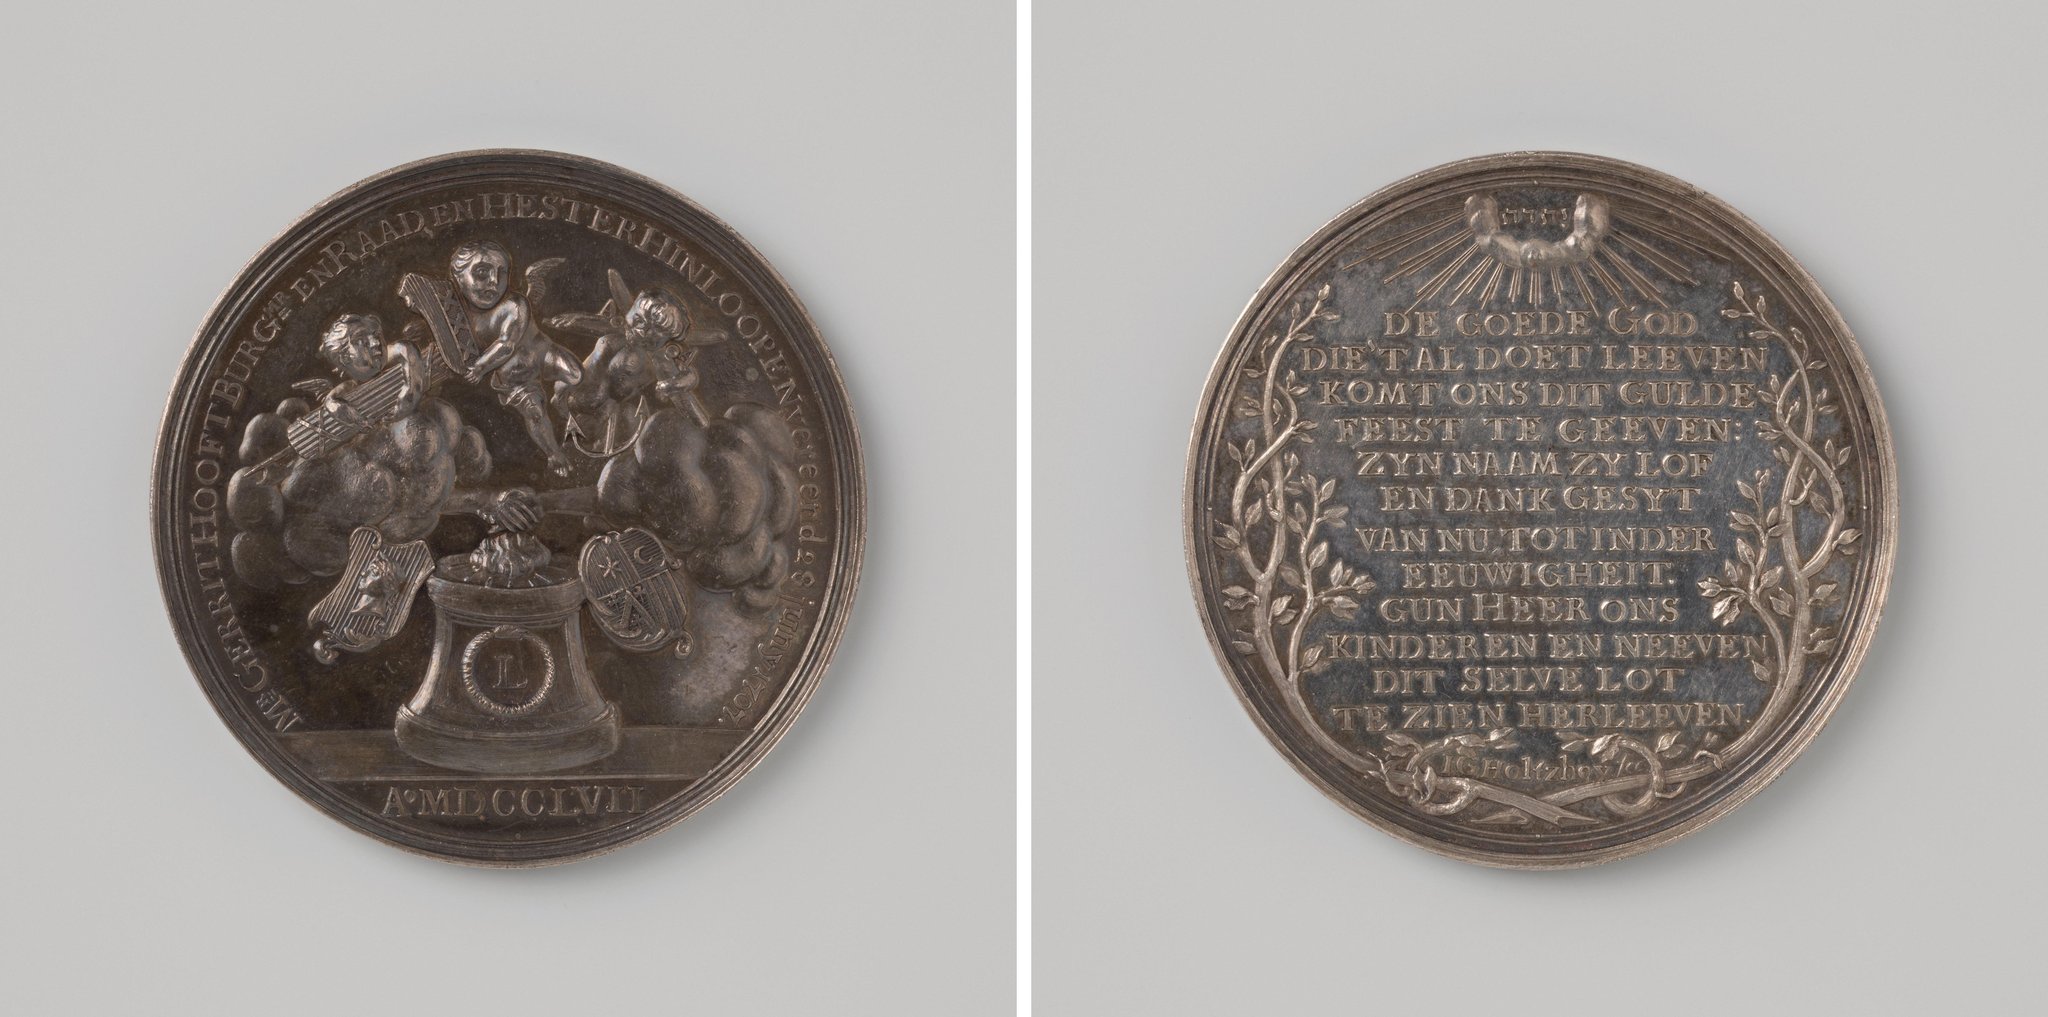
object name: history medal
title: Vijftigjarig huwelijk van Gerrit Hooft, burgemeester van Amsterdam, en Hester Hinloopen 1757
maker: johan george holtzhey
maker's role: mintmaster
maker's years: 1726-1808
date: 1757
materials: silver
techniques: striking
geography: amsterdam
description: Zilveren penning,op de voorzijde boven een altaar twee ineengedrukte handen uit wolken waaraan familiewapens hangen, waarboven drie gevleugelde knaapjes met fasces, Amsterdams stadswapenschild en anker, met omschrift en in afsnede A° MDCCLVII, op de keerzijde onder een stralende wolk met godsnaam twaalf regels tekst tussen bladranken.